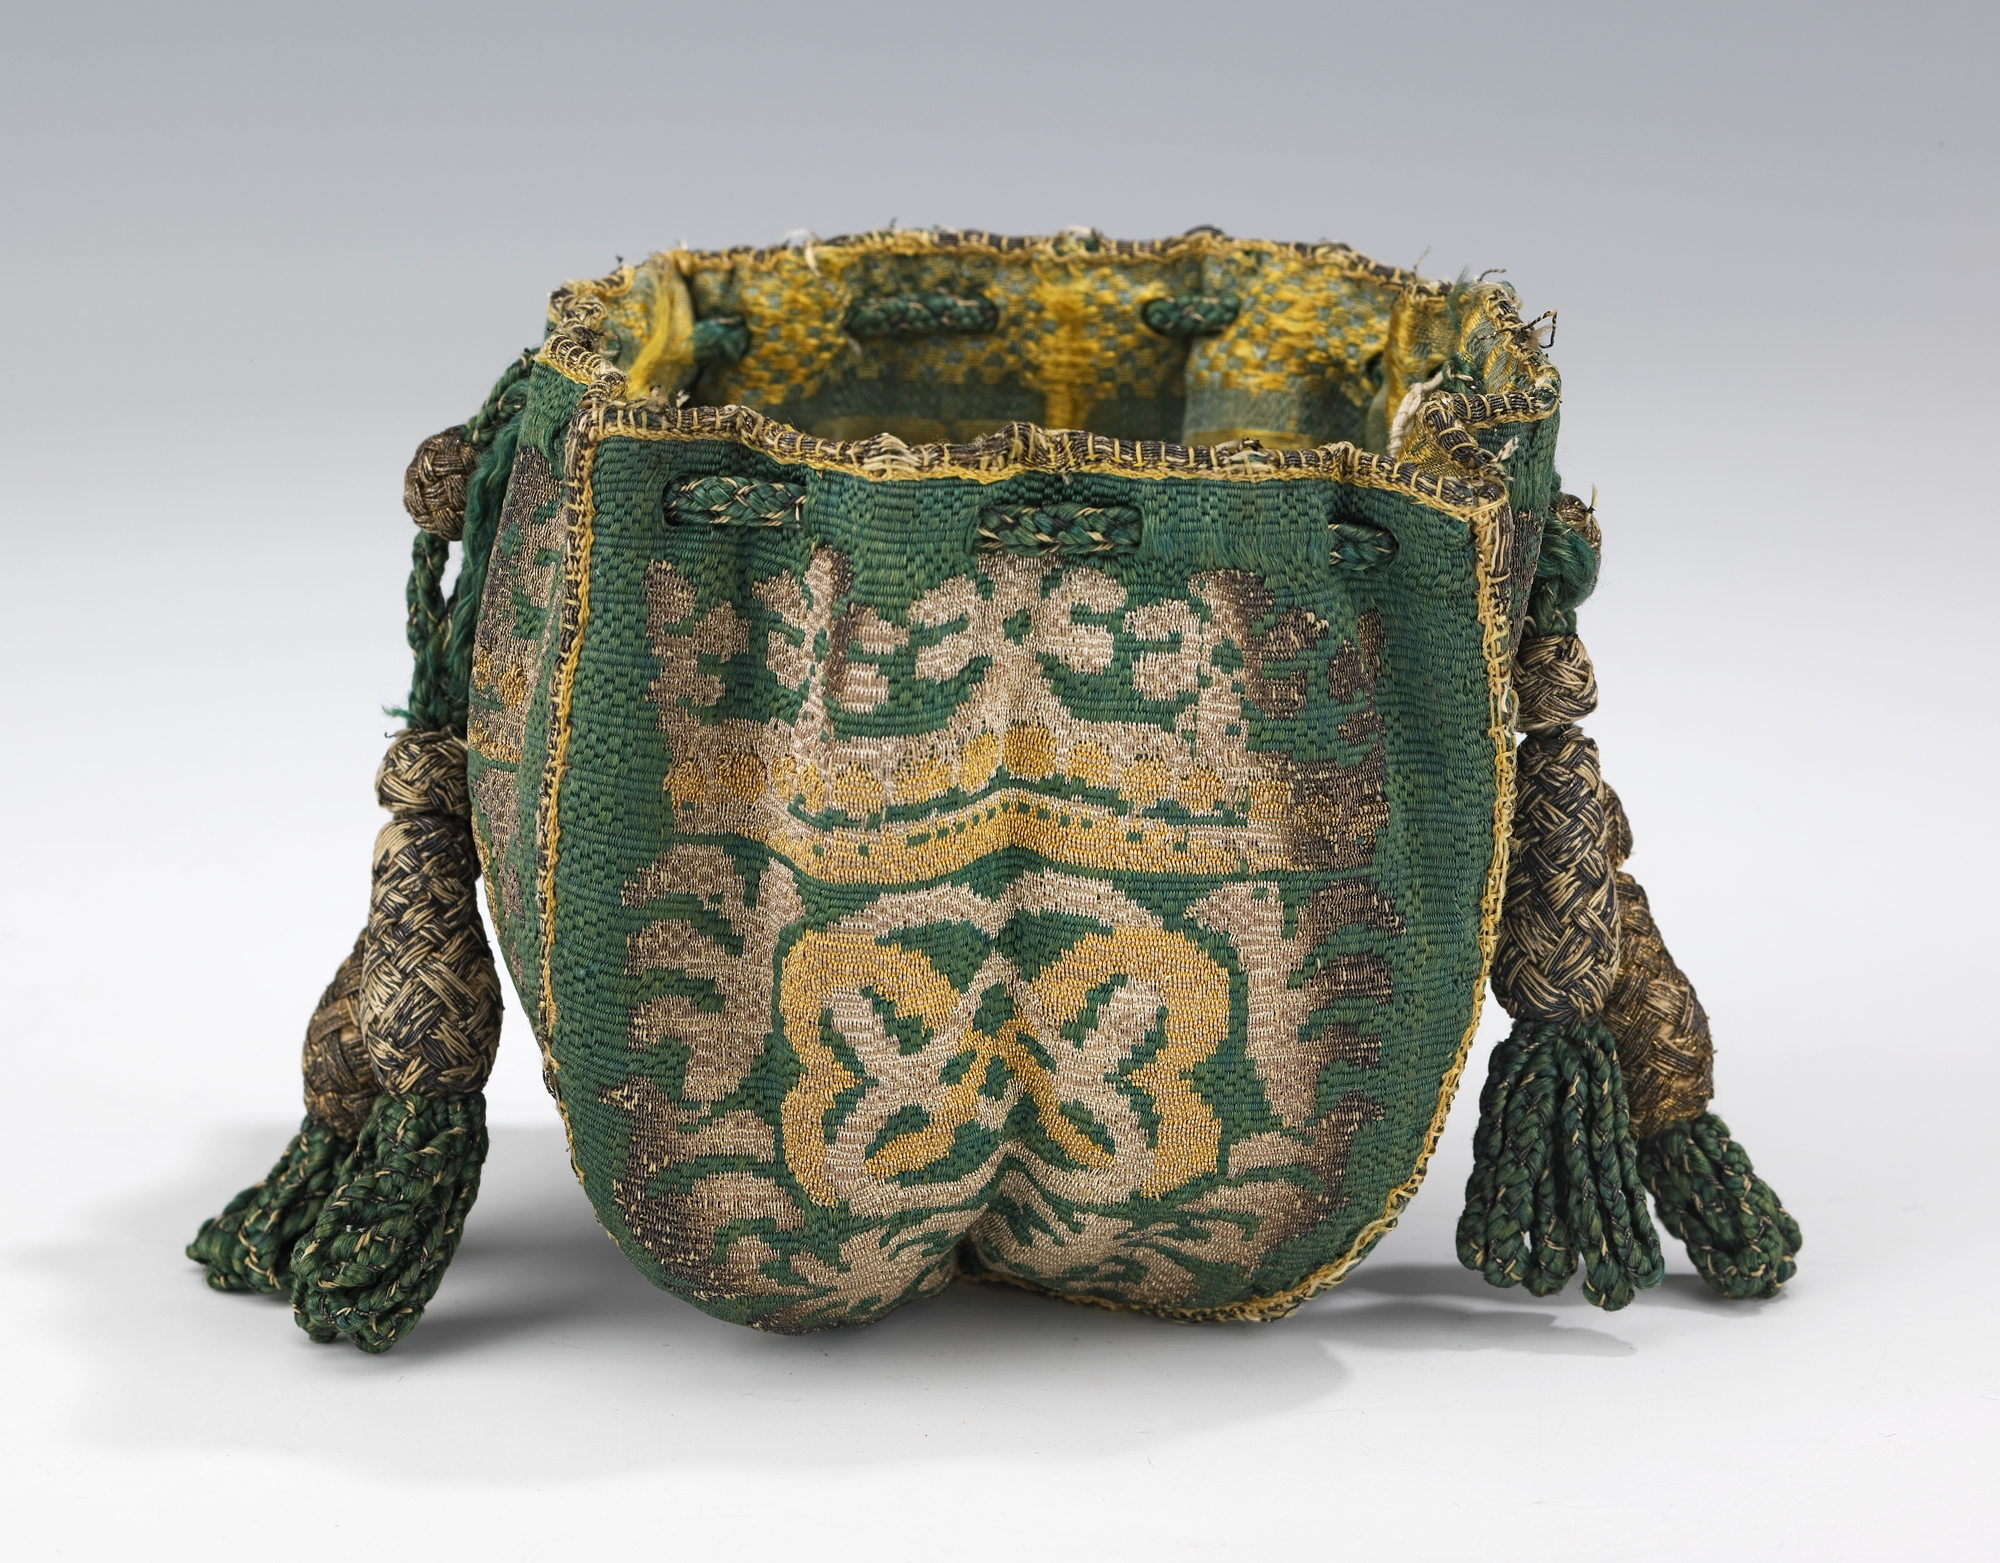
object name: pouch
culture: european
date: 1676-1700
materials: metal, silk